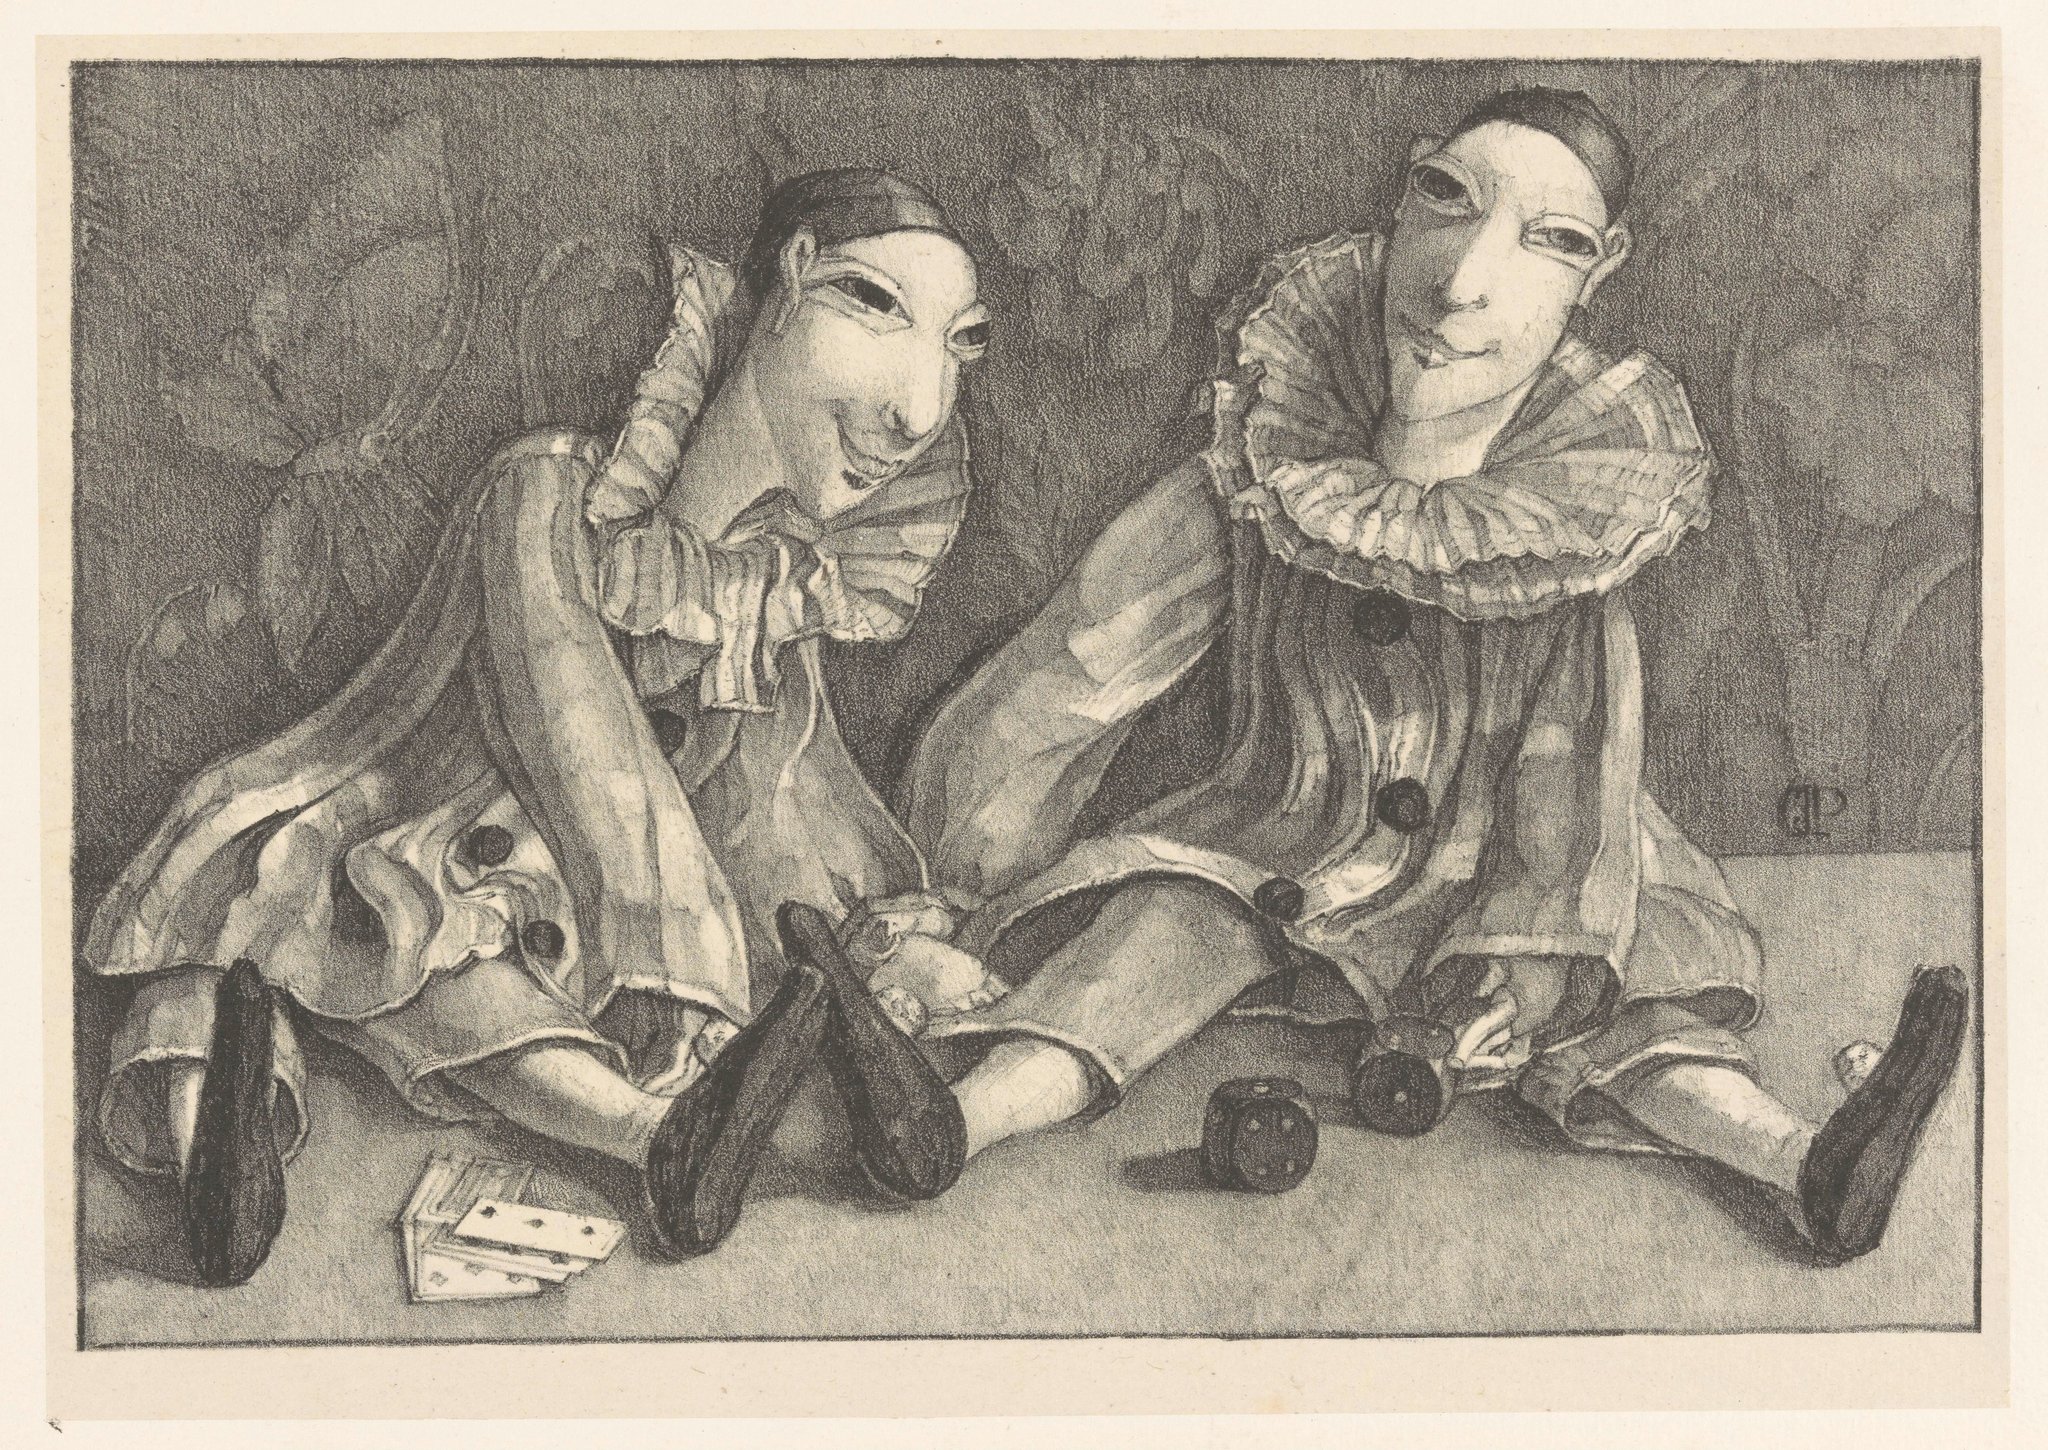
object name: print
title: Twee poppen in clownskostuum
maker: corrie pabst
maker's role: print maker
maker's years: 1866-1943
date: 1926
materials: paper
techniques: lithograph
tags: (playing with) dolls, clown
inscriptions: collector's mark: Lugt 2228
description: Bij de poppen liggen speelkaarten en twee dobbelstenen.